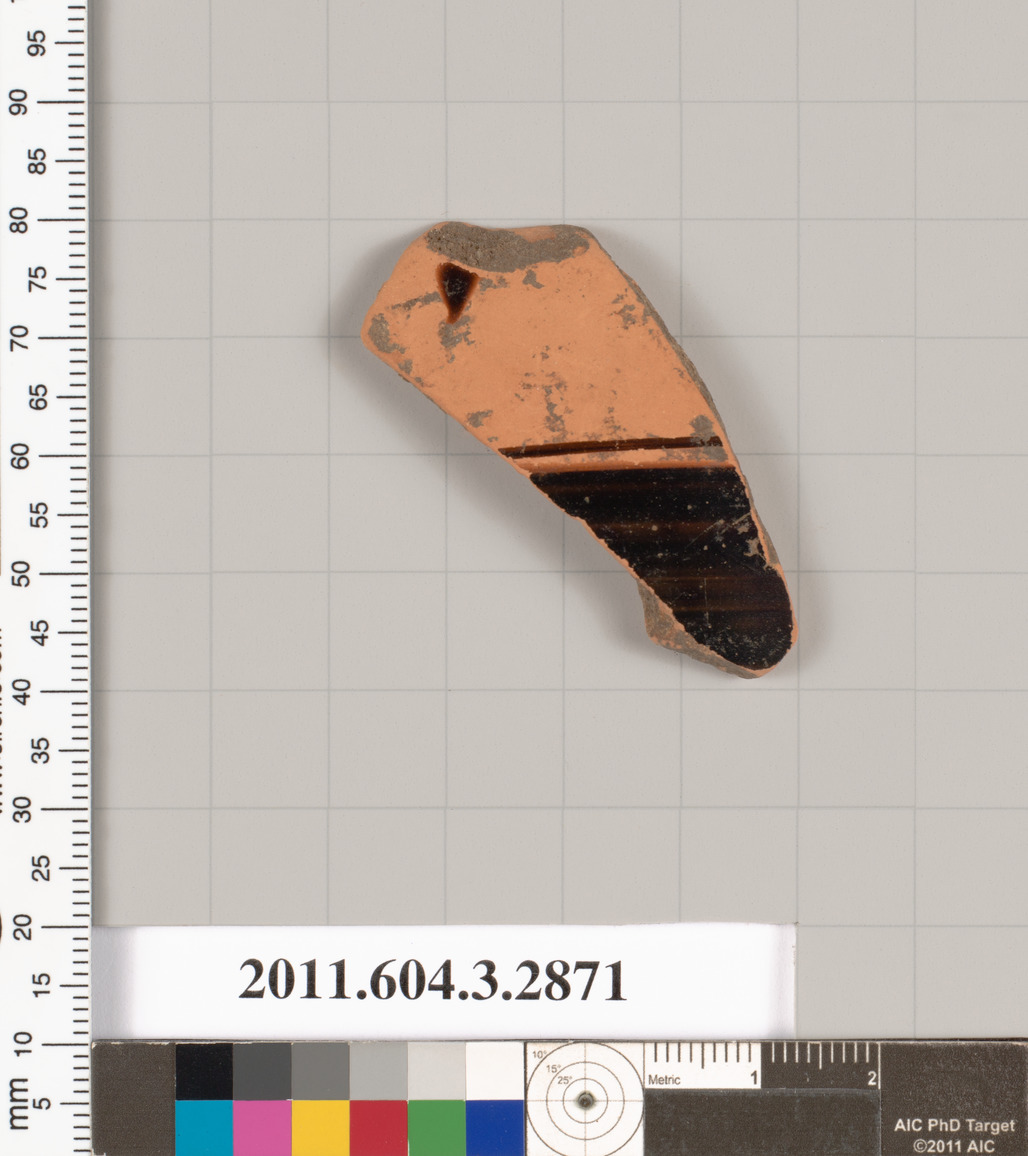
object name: undetermined closed shape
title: Terracotta fragment of a closed shape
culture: greek, attic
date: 600-401 BCE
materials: terracotta